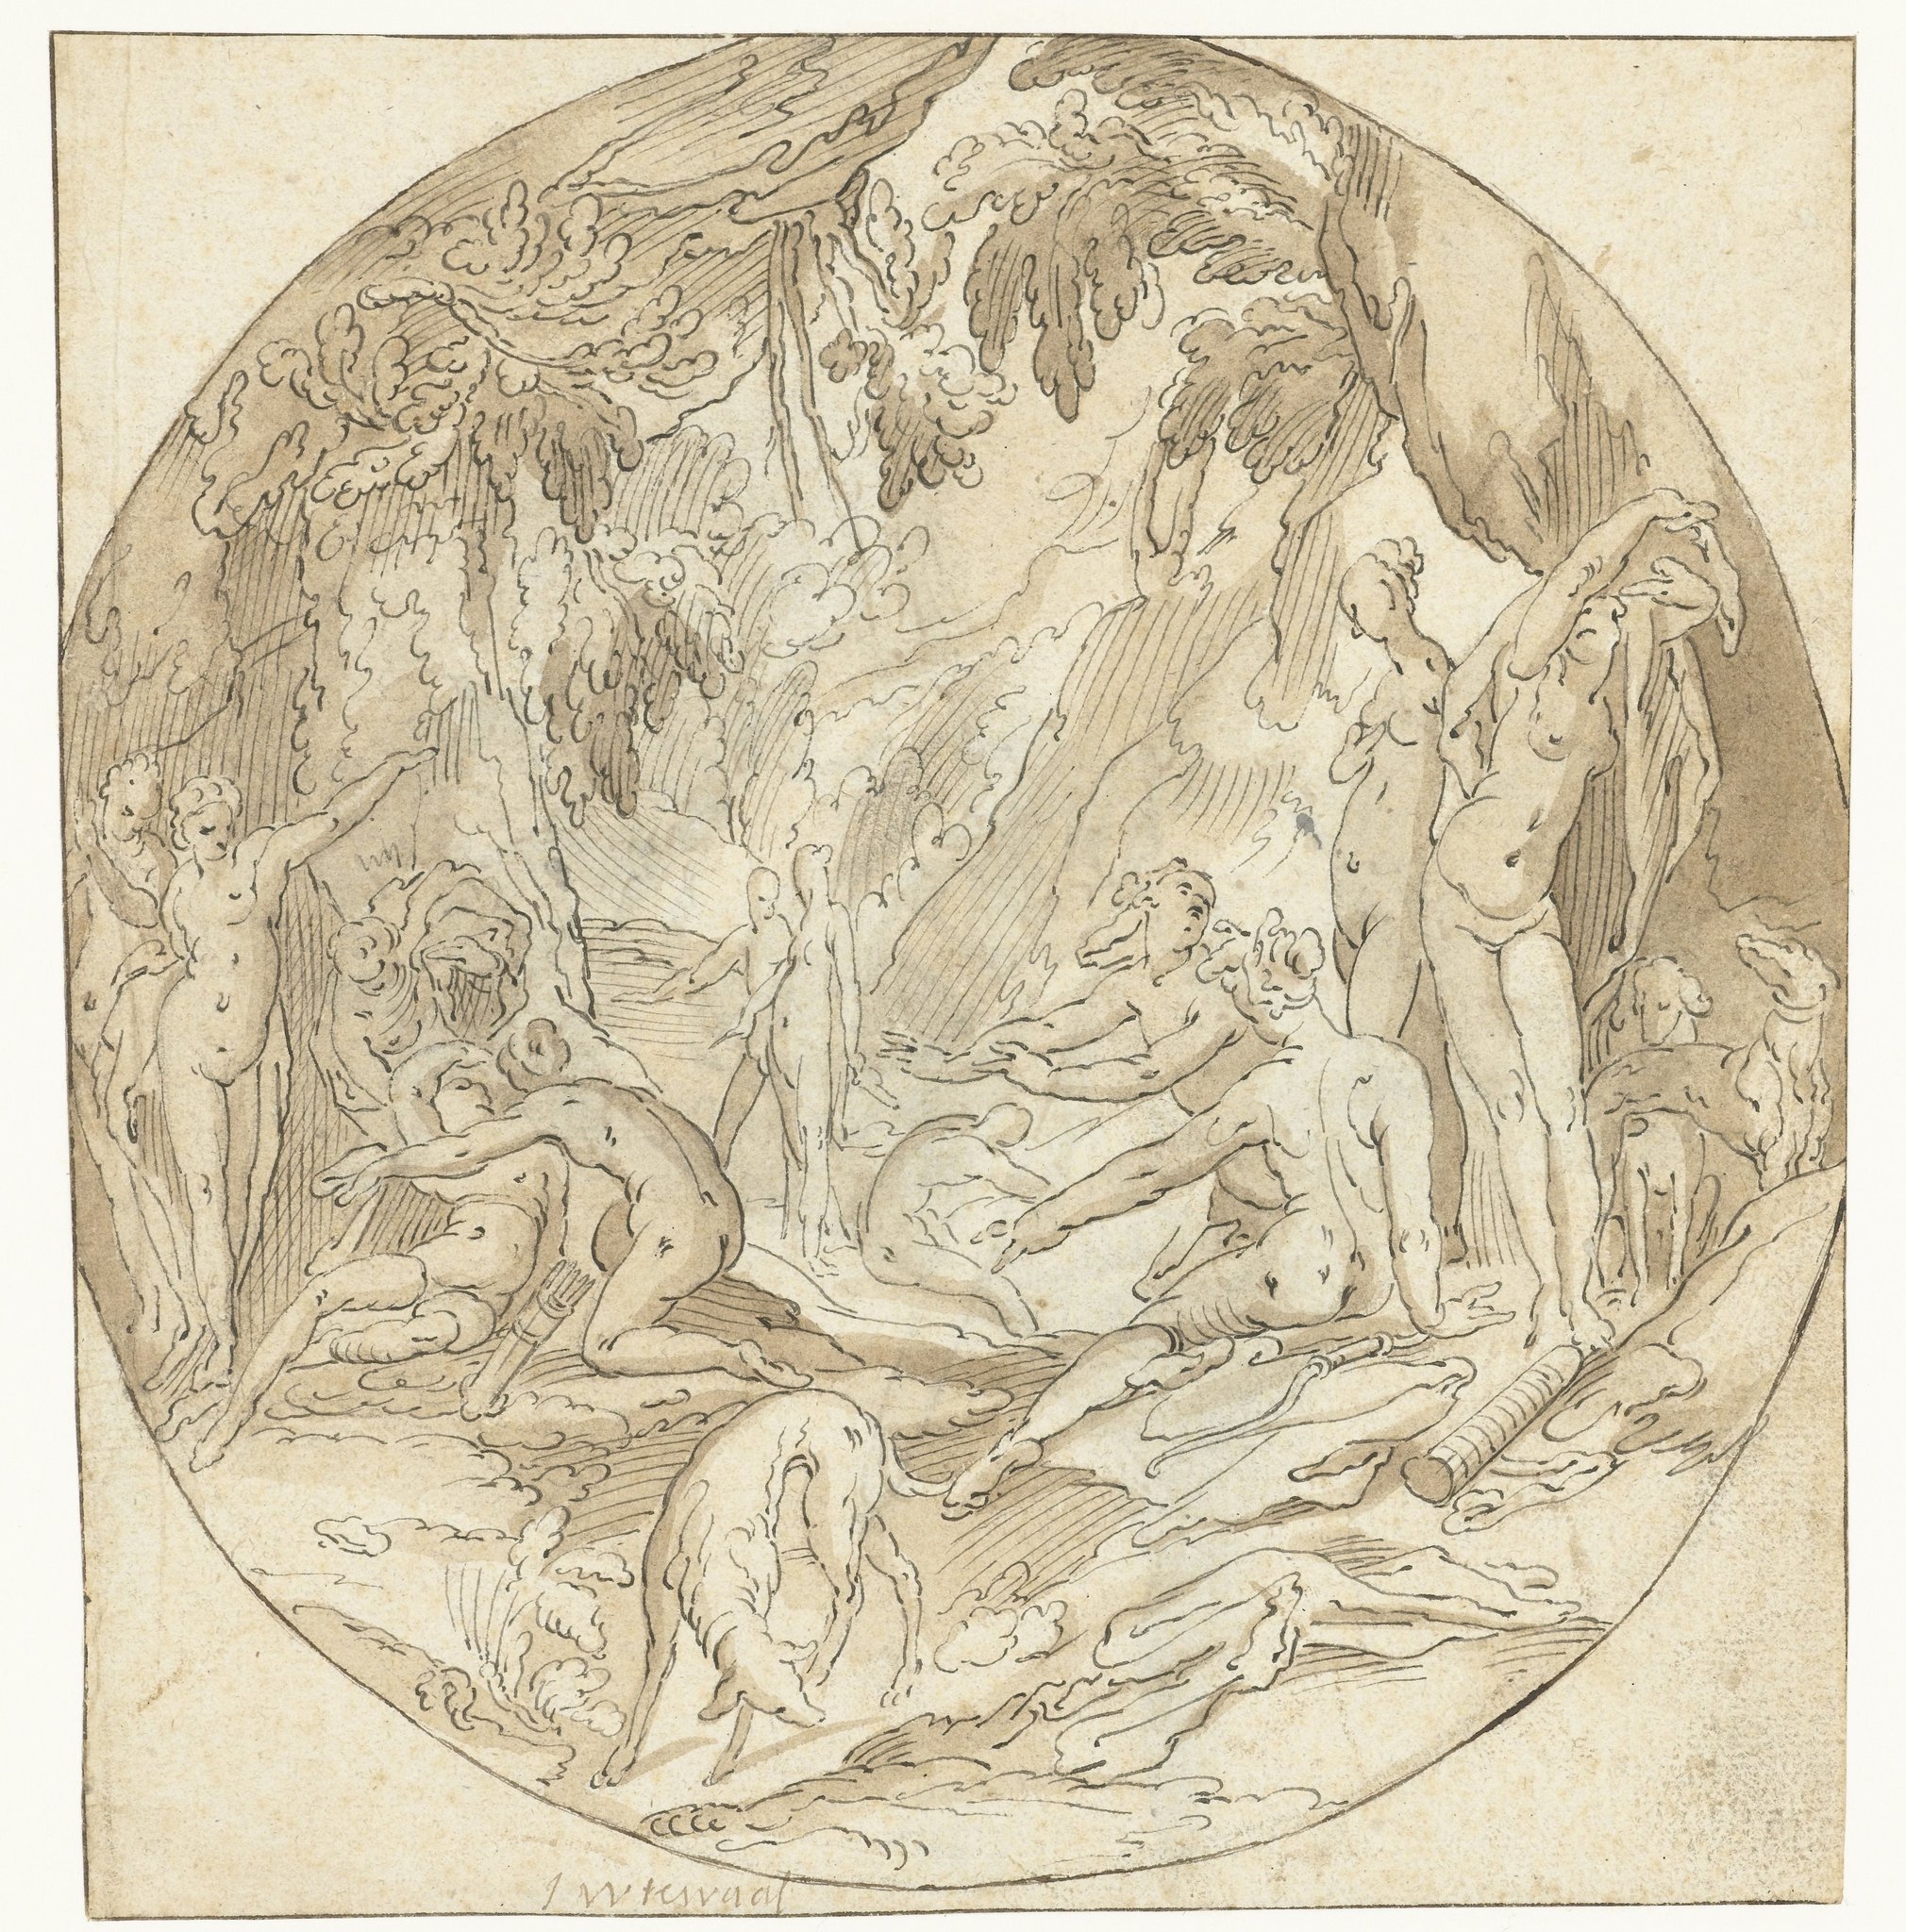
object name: drawing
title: Diana ontdekt Callisto's zwangerschap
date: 1576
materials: chalk, ink, paper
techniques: brush, pen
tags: diana with her nymphs discovers the pregnancy of callisto, pregnancy